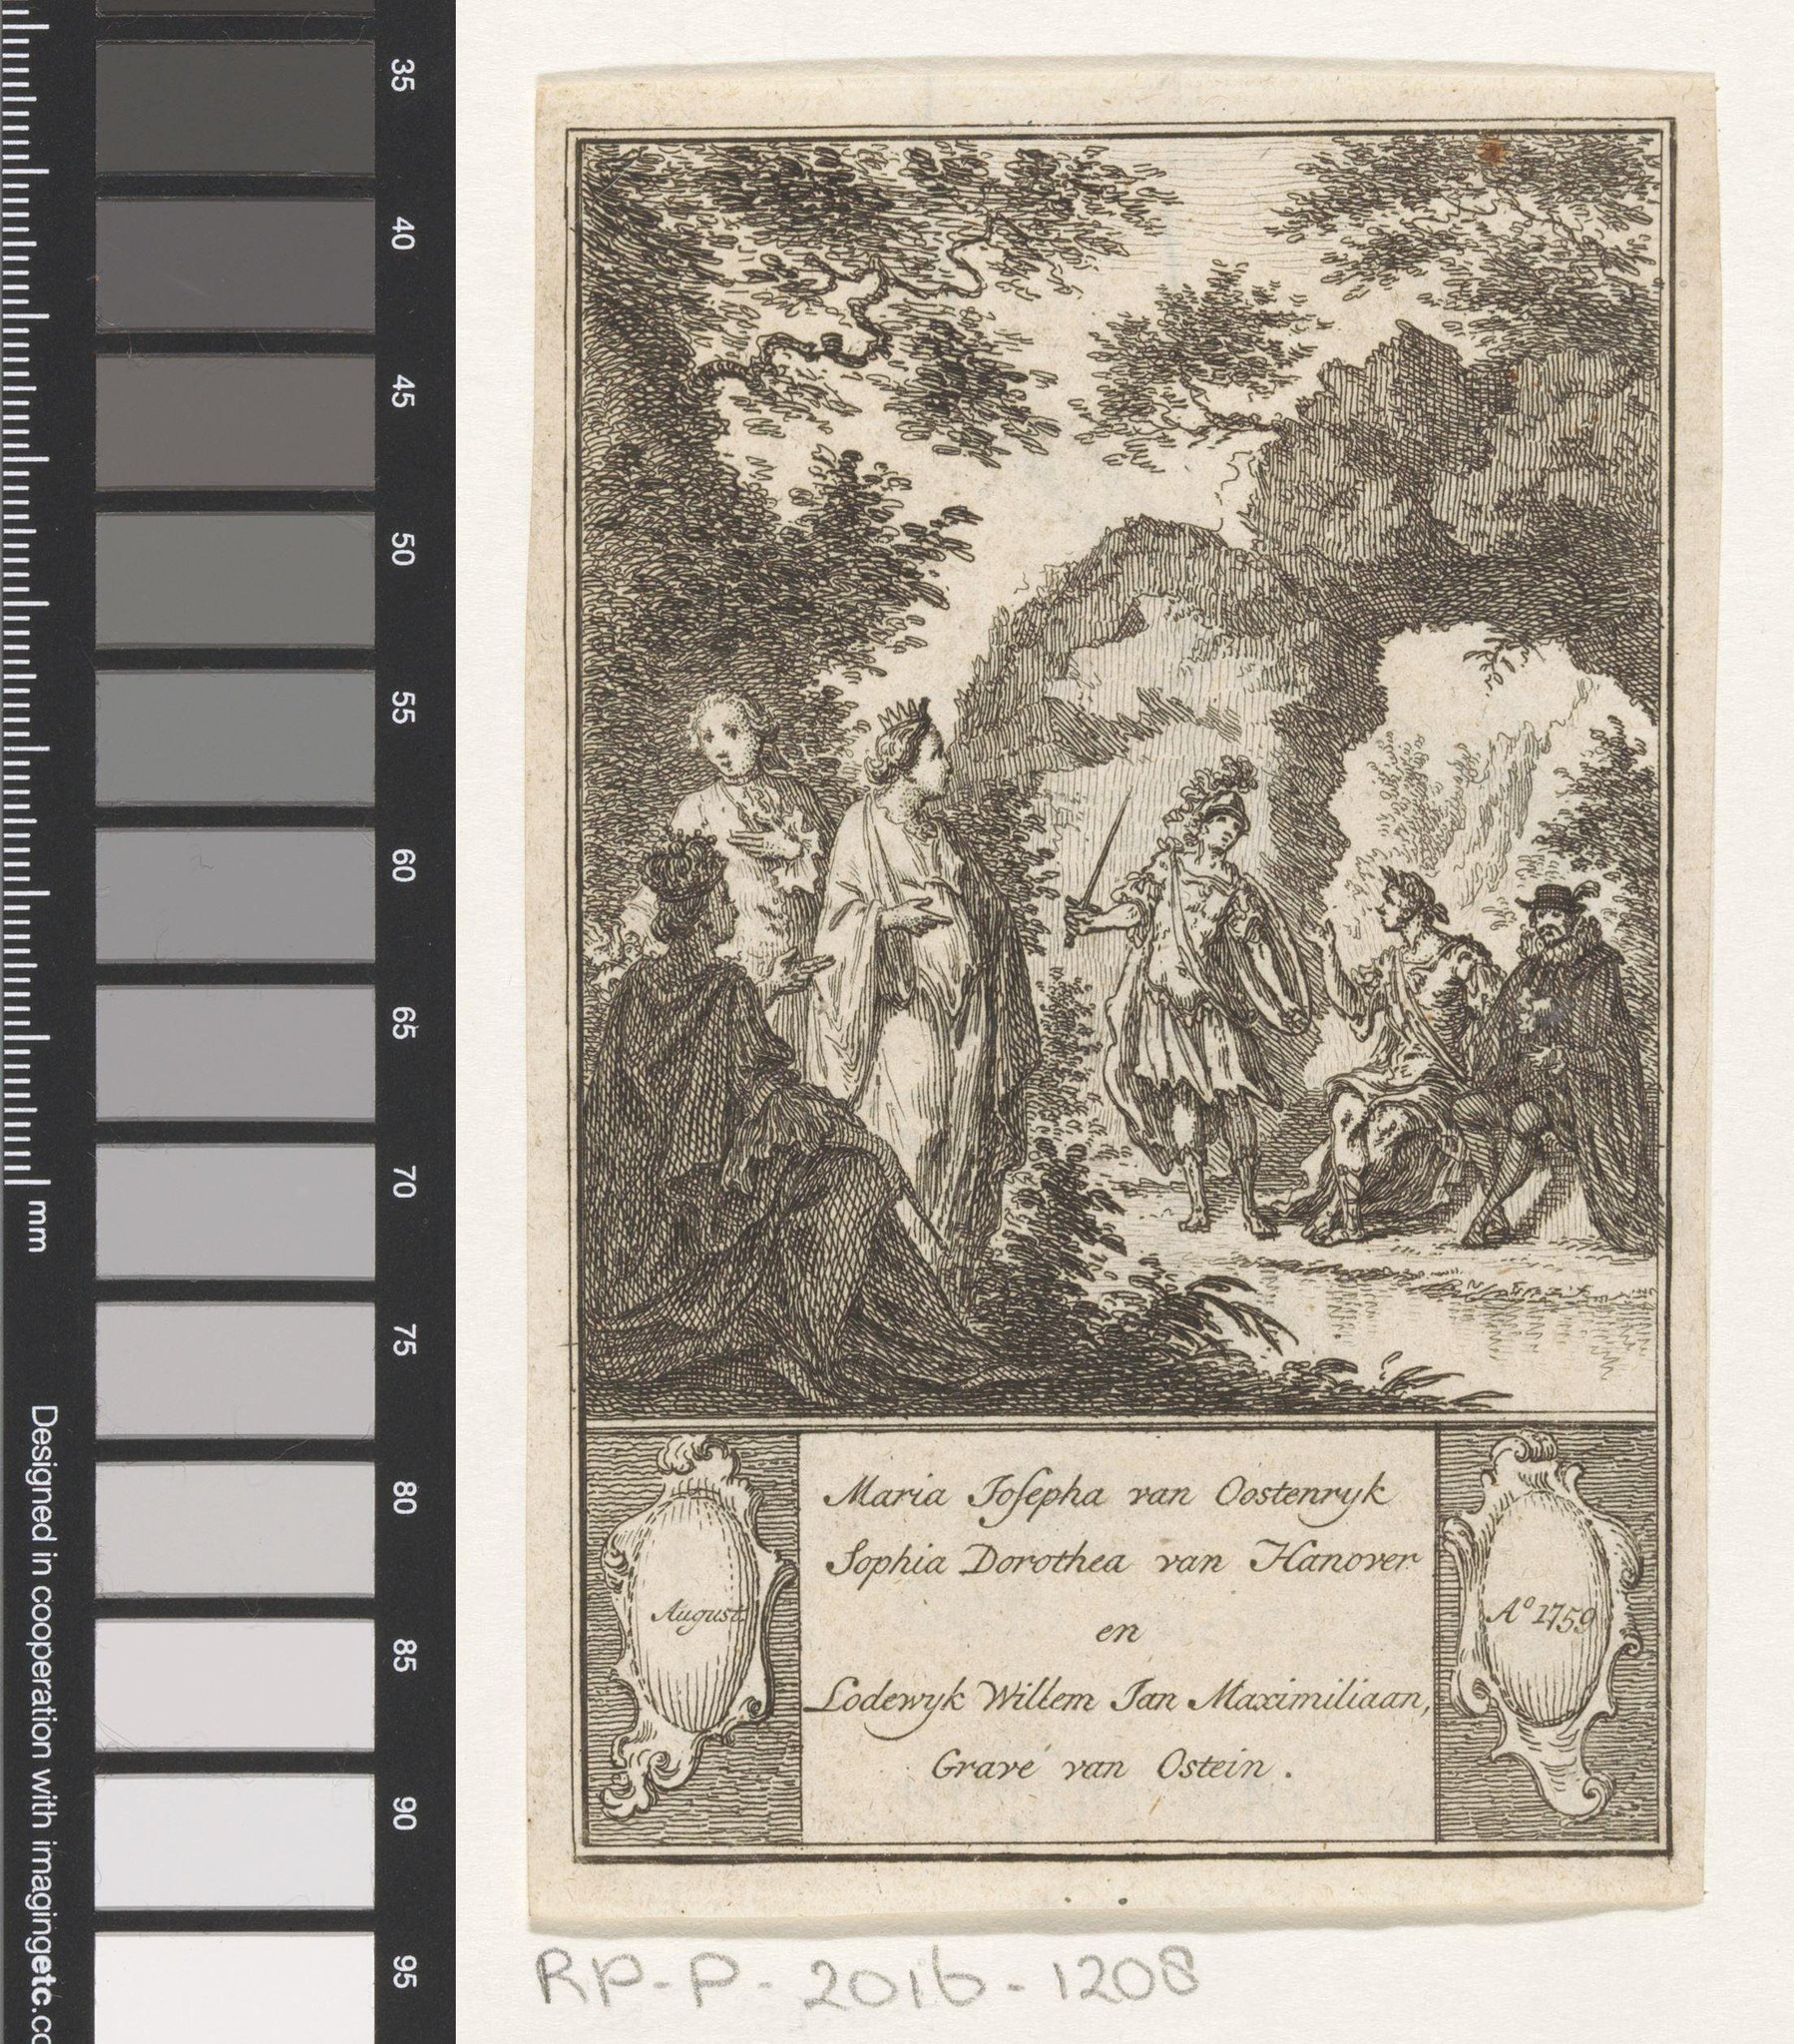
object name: book illustration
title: Gesprek tussen Maria Josepha van Oostenrijk, Sophia Dorothea van Hannover en Lodewijk Willem Johan Maximiliaan Graaf van Ostein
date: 1708-1759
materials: paper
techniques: etching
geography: amsterdam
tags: vienna, berlin, conversation, dialogue; conversation piece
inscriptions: collector's mark: Lugt 2228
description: In een landschap staan de koninginnen Maria Josepha van Oostenrijk en Sophia Dorothea van Hannover en de graaf van Ostein Lodewijk Willem Johan Maximiliaan bij een rivier. Aan de overkant daarvan zitten een man en een keizer en staat een figuur in harnas. Aan de onderzijde op twee cartouches vermeld: August / Ao 1759.